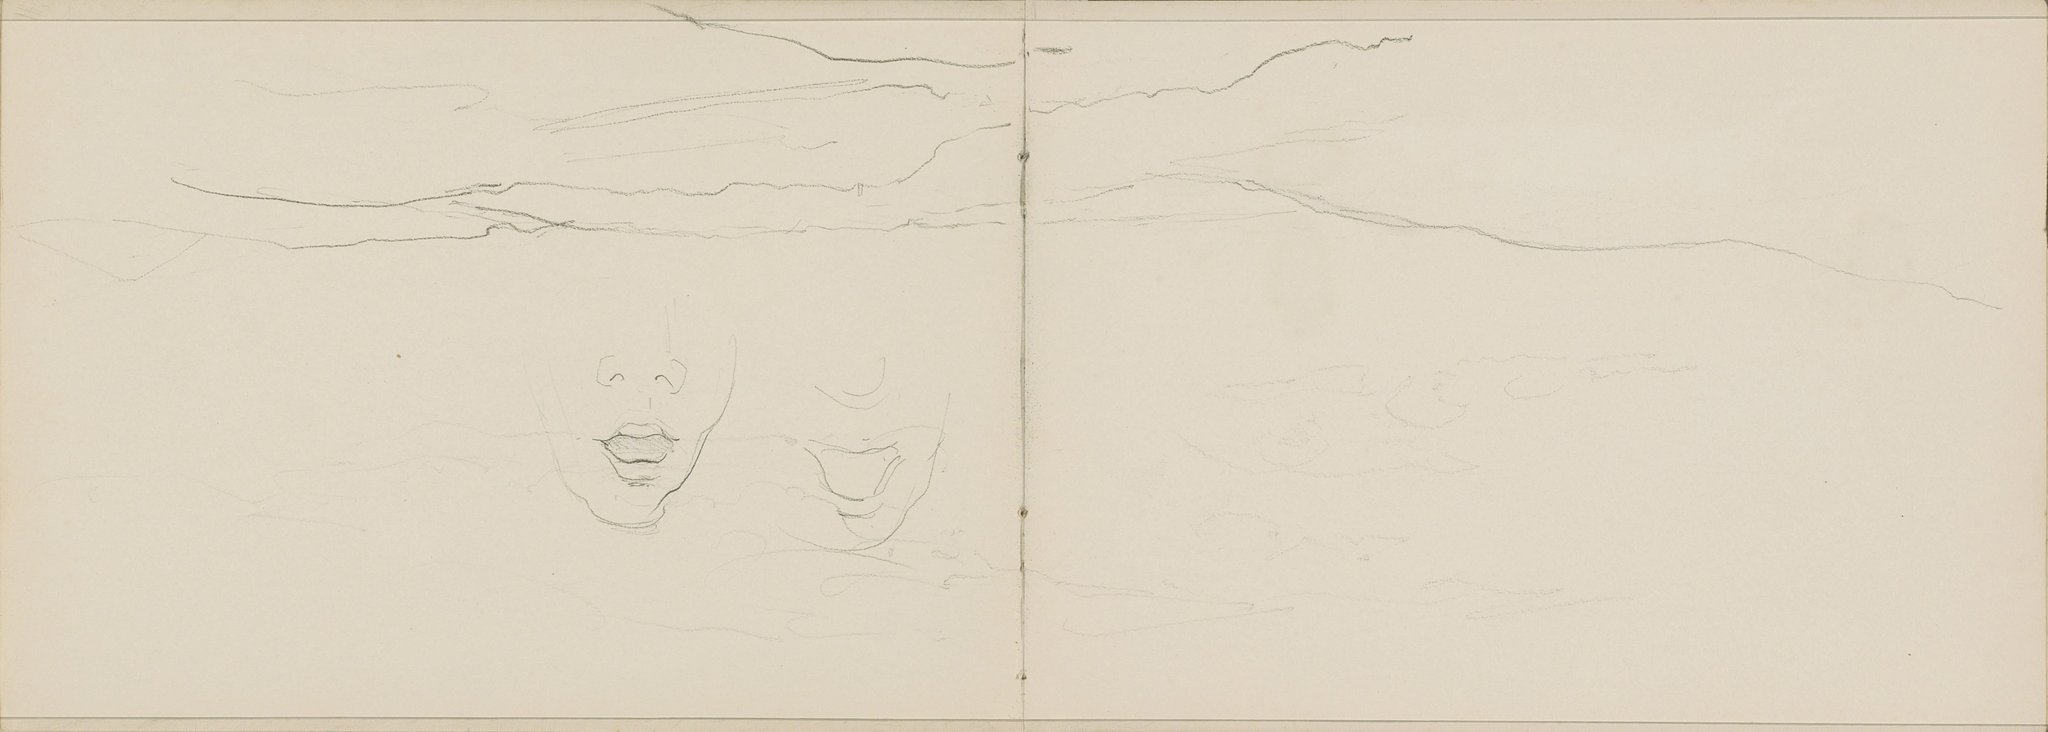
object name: sketchbook leaf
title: Wolkenlucht en twee koppen met open monden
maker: a.a.l. de grammont-hubrecht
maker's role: draughtsman, painter, print maker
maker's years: 1855-1913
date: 1865-1913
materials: chalk, paper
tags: mouth wide open, head (human), clouds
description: Blad 63 verso en 64 recto uit een schetsboek met 68 bladen.